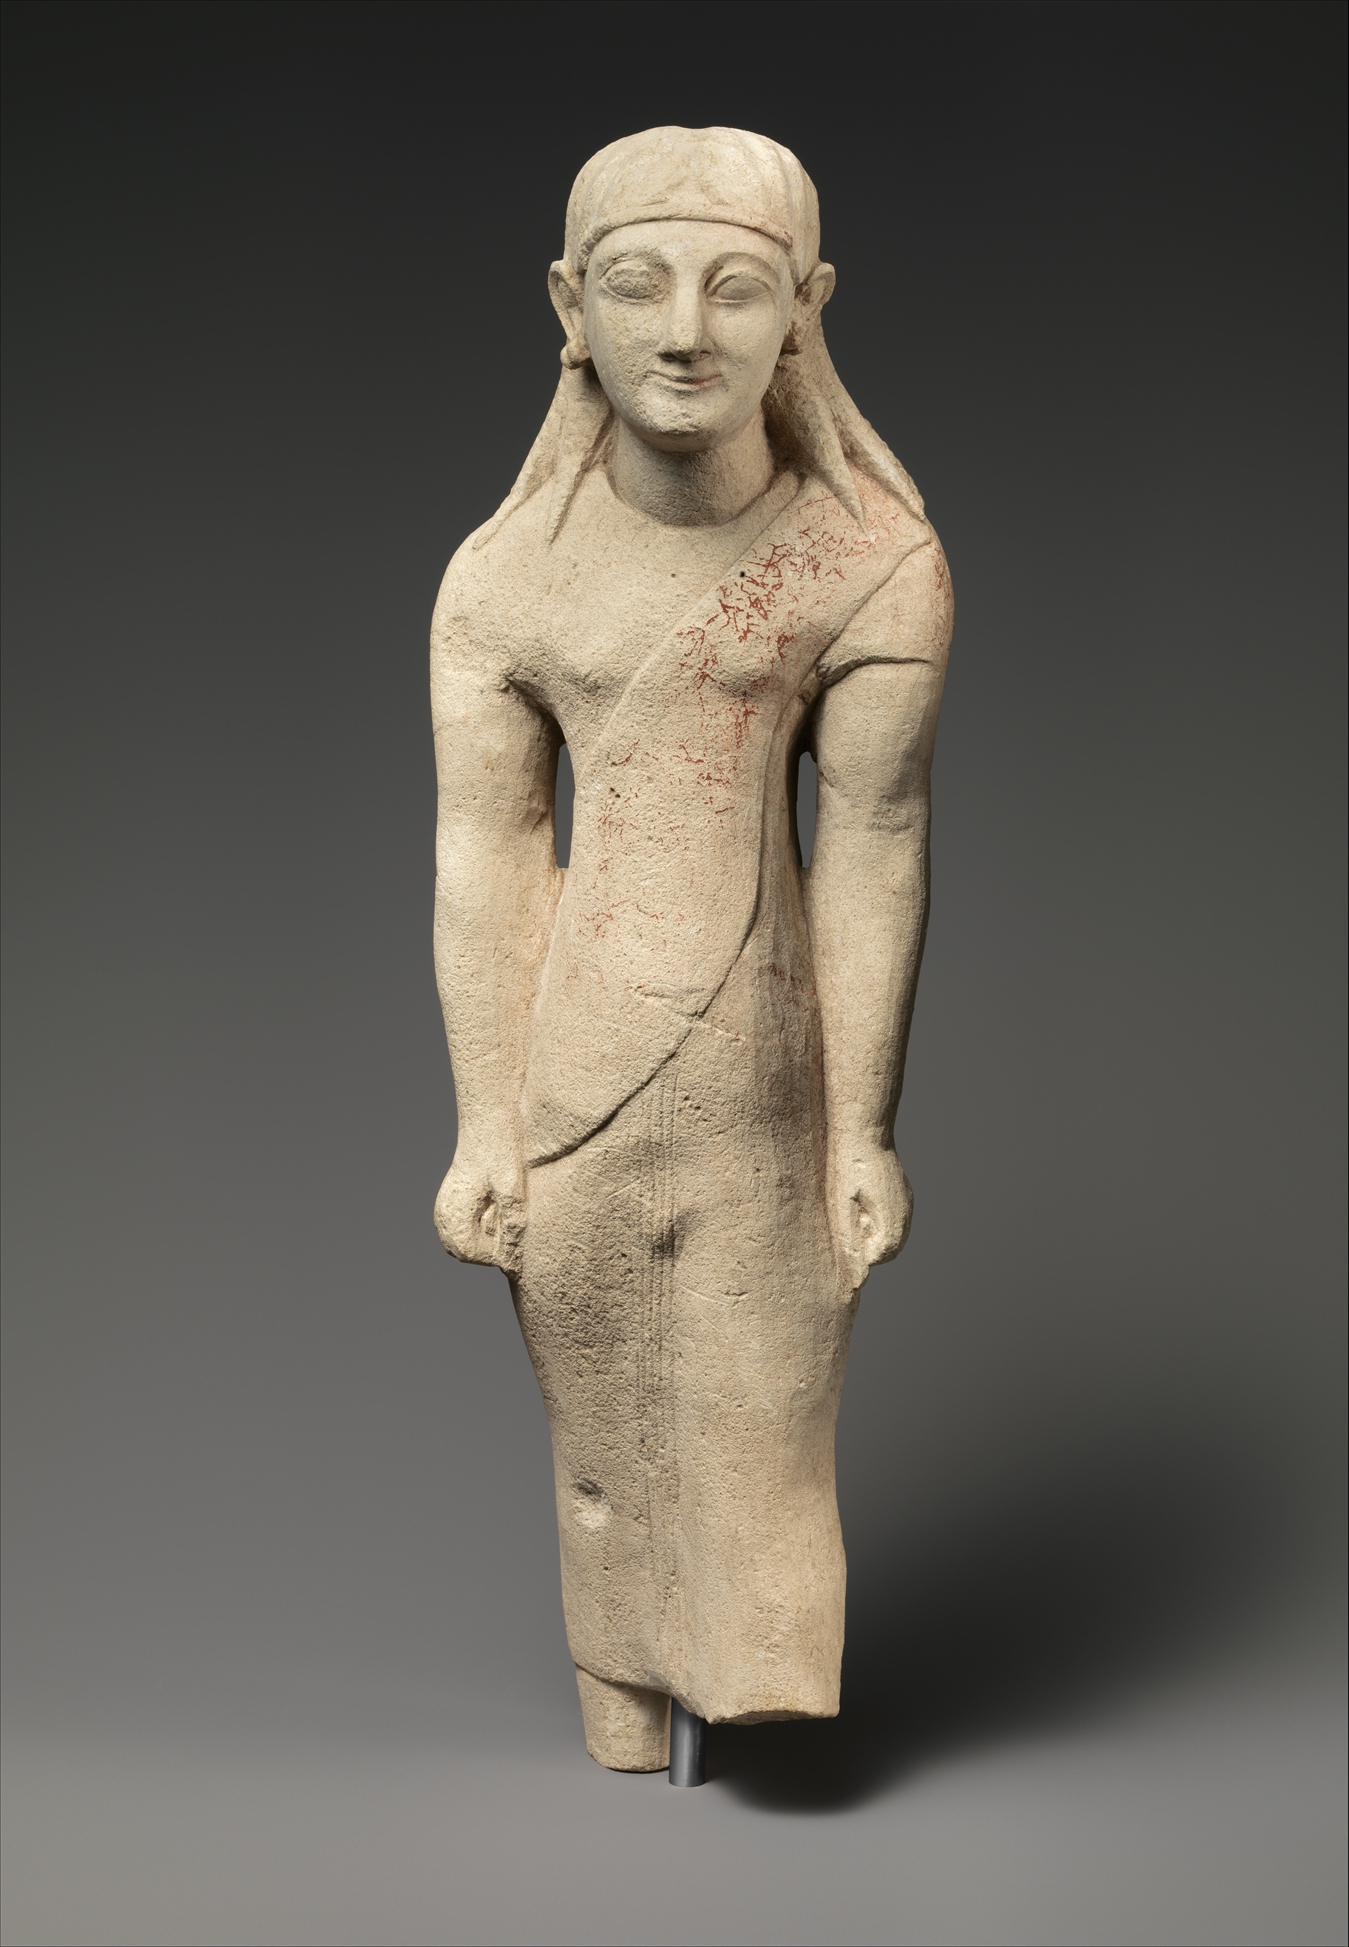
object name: statue of a youth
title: Limestone youth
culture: cypriot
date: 600-551 BCE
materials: limestone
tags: men